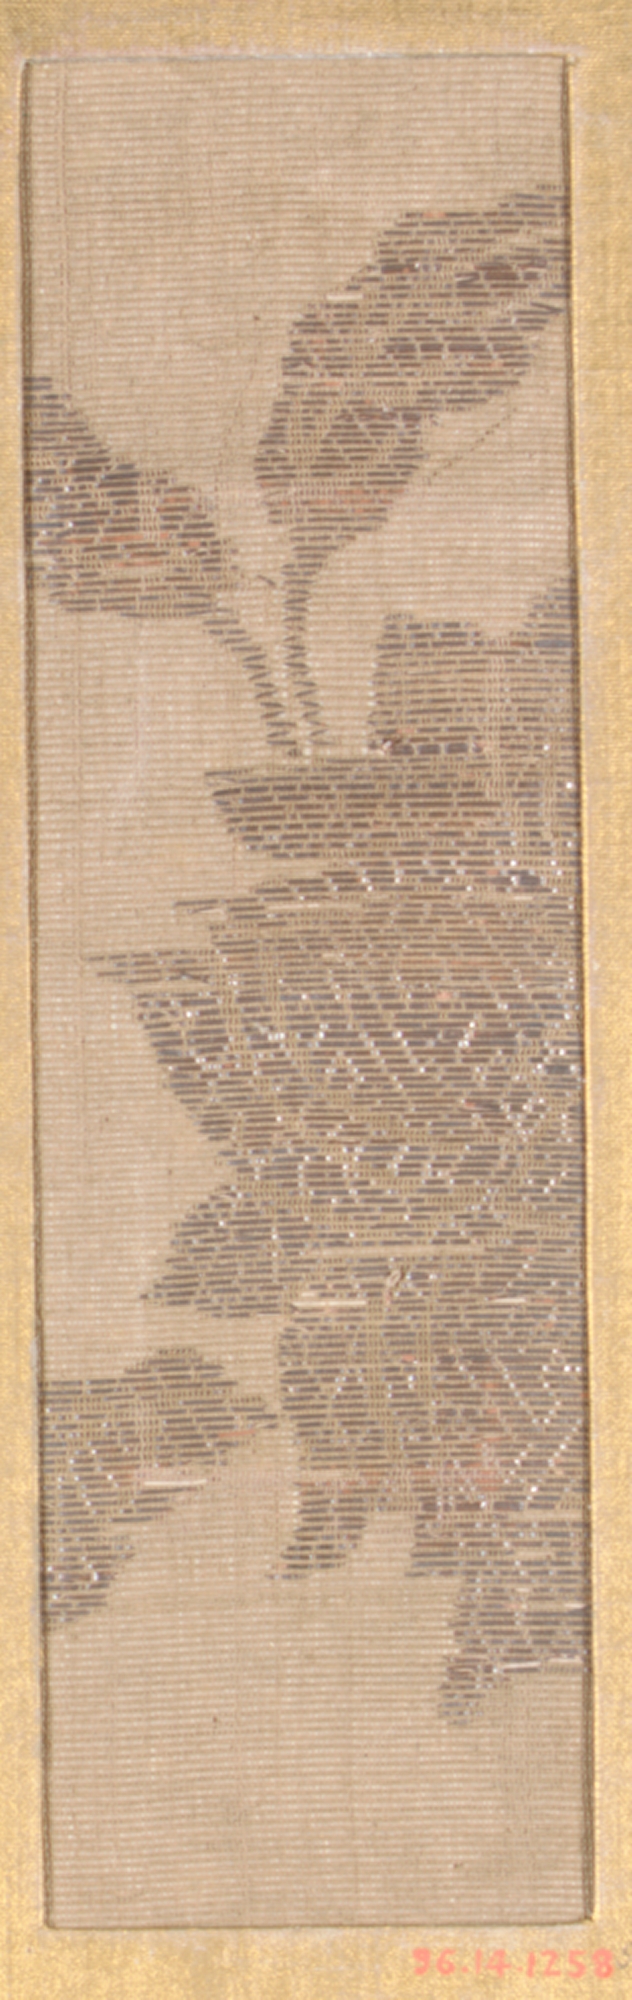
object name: piece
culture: japanese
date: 1701-1900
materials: silk